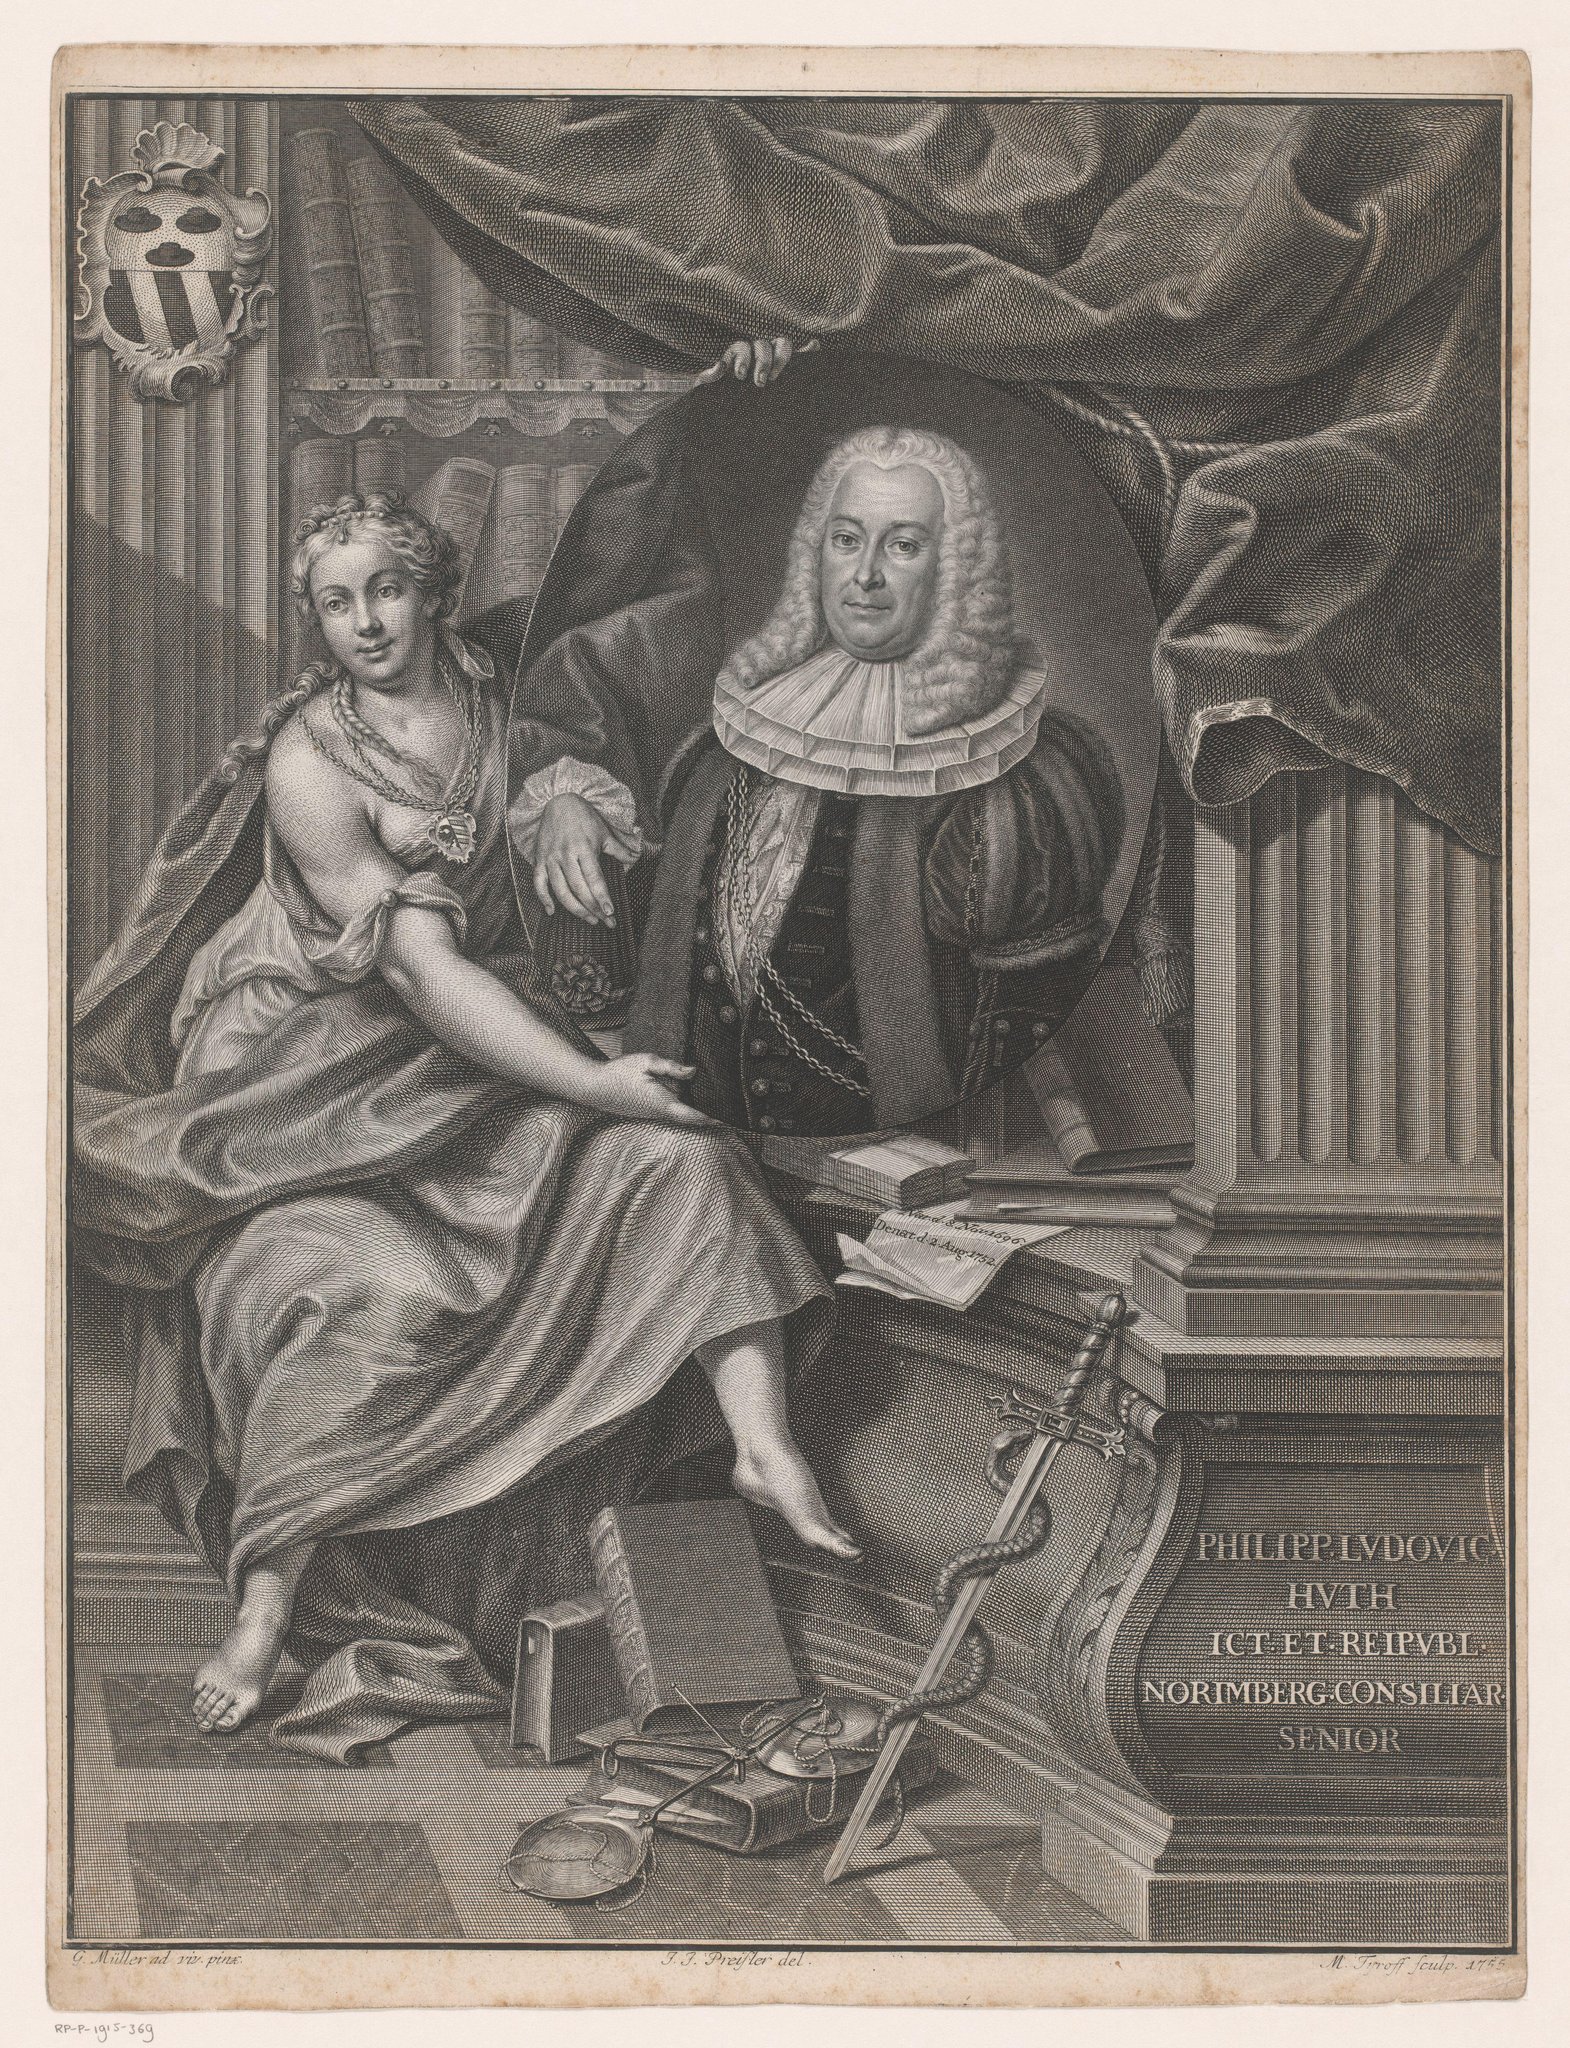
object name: print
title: Portret van Philipp Ludwig Huth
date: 1755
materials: paper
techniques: engraving, etching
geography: nuremberg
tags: historical persons, scales, justitia (justice) as roman personification, armorial bearing, heraldry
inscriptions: collector's mark: Lugt 2228